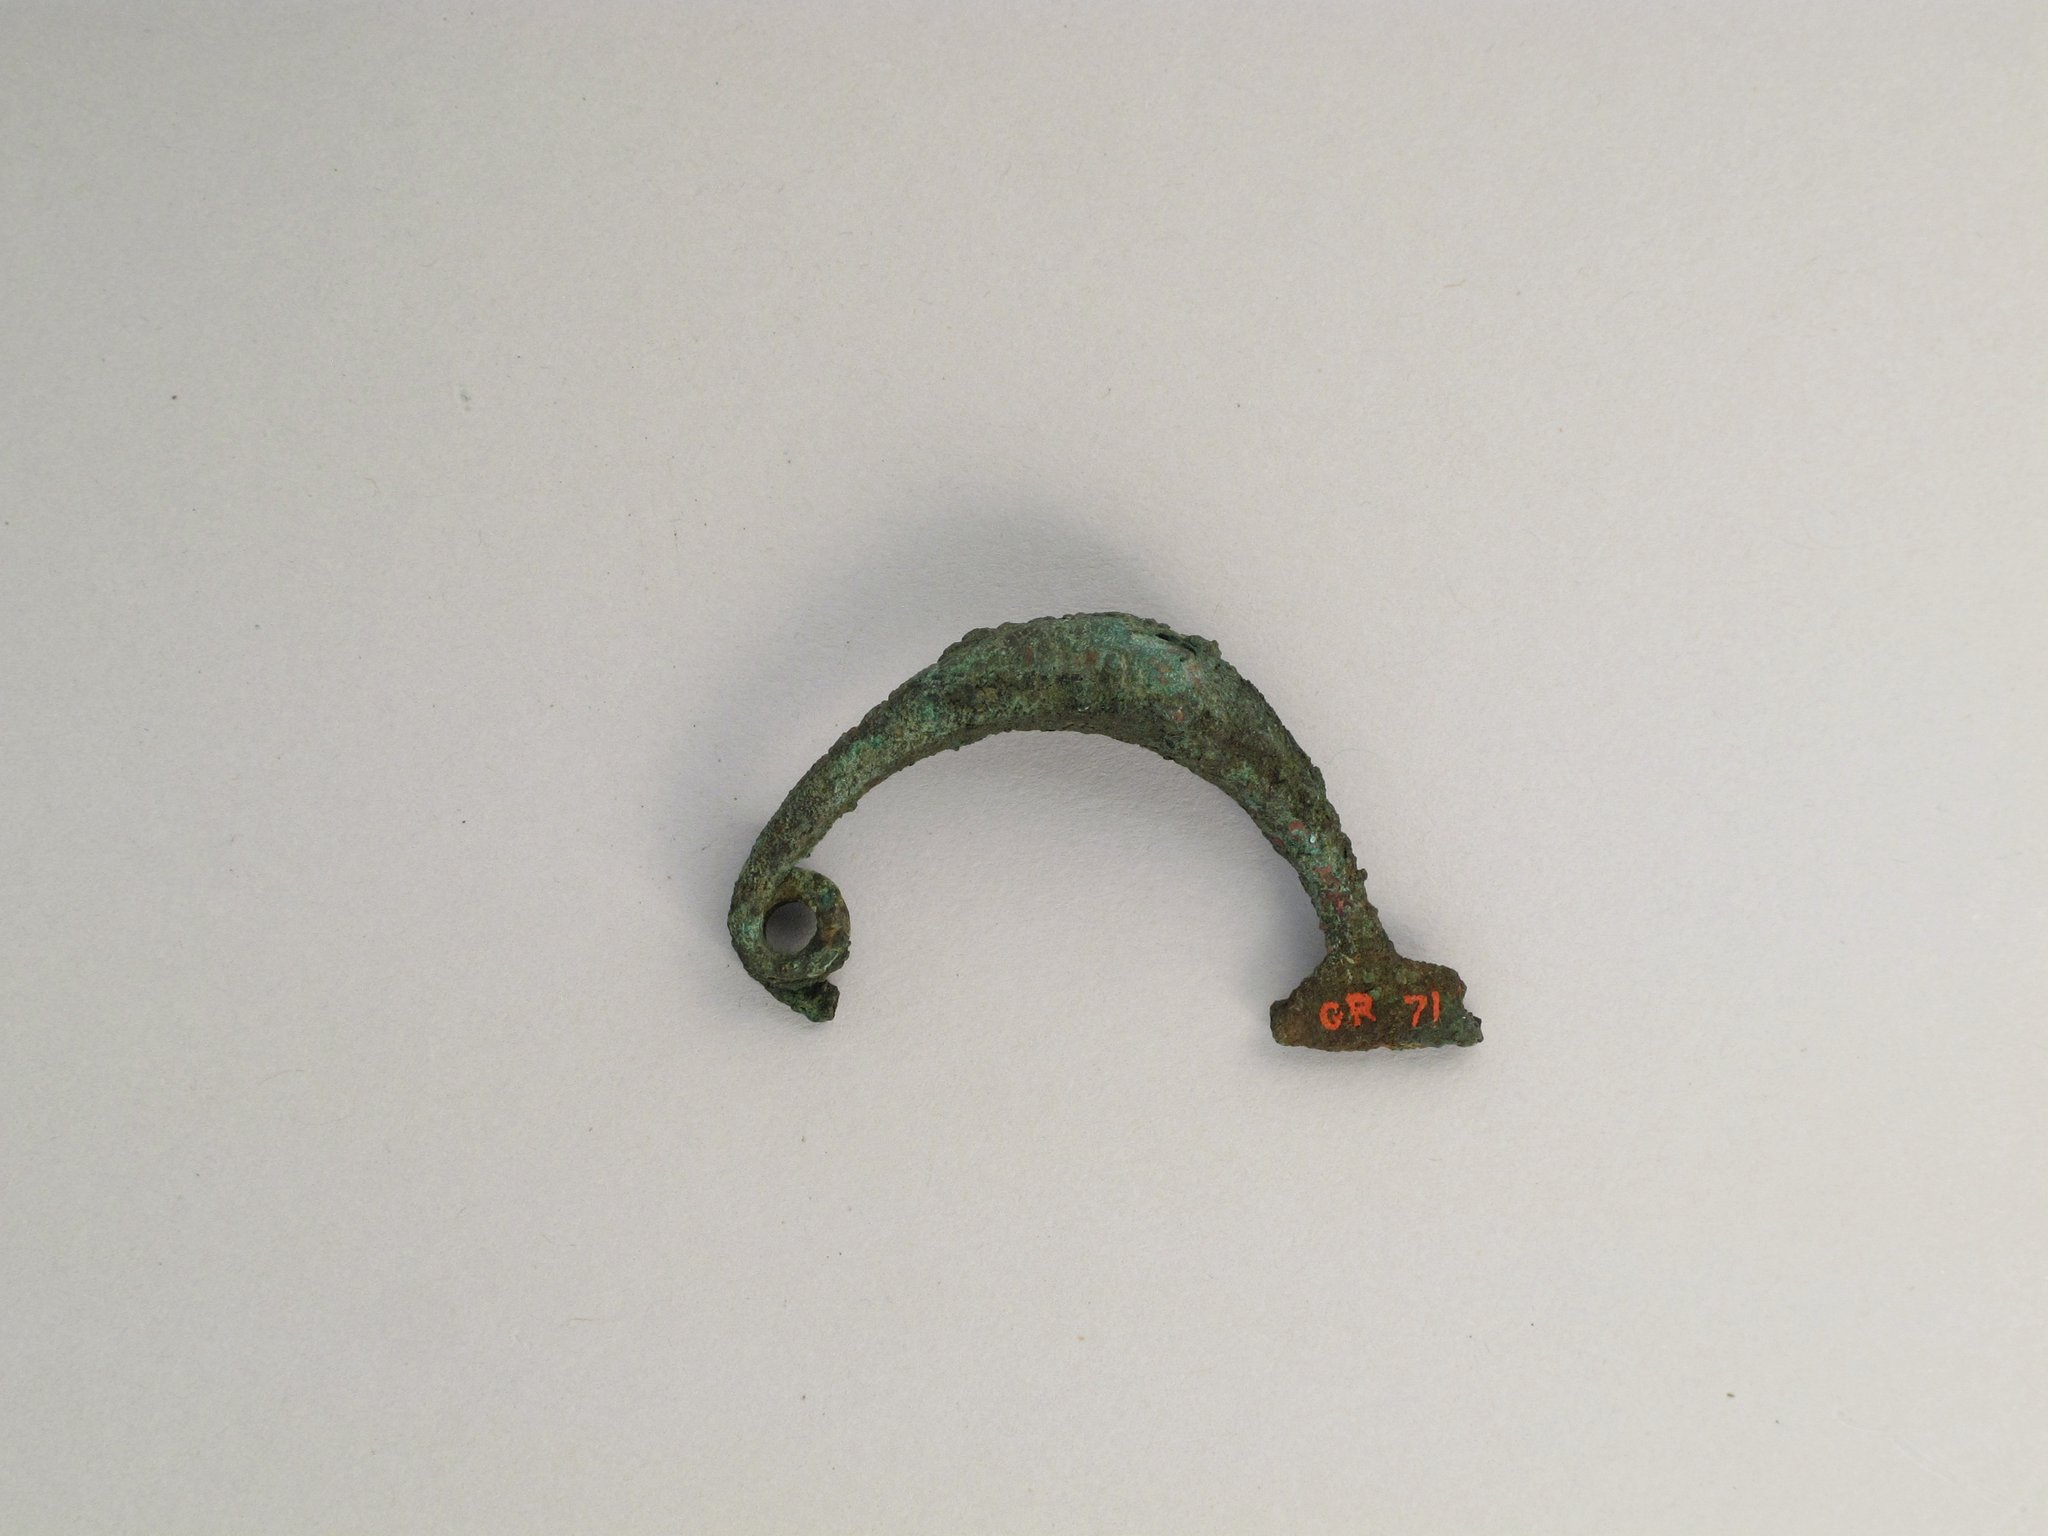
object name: fibula, boat shaped type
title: Fibula, boat-shaped type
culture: italic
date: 800-501 BCE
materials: bronze